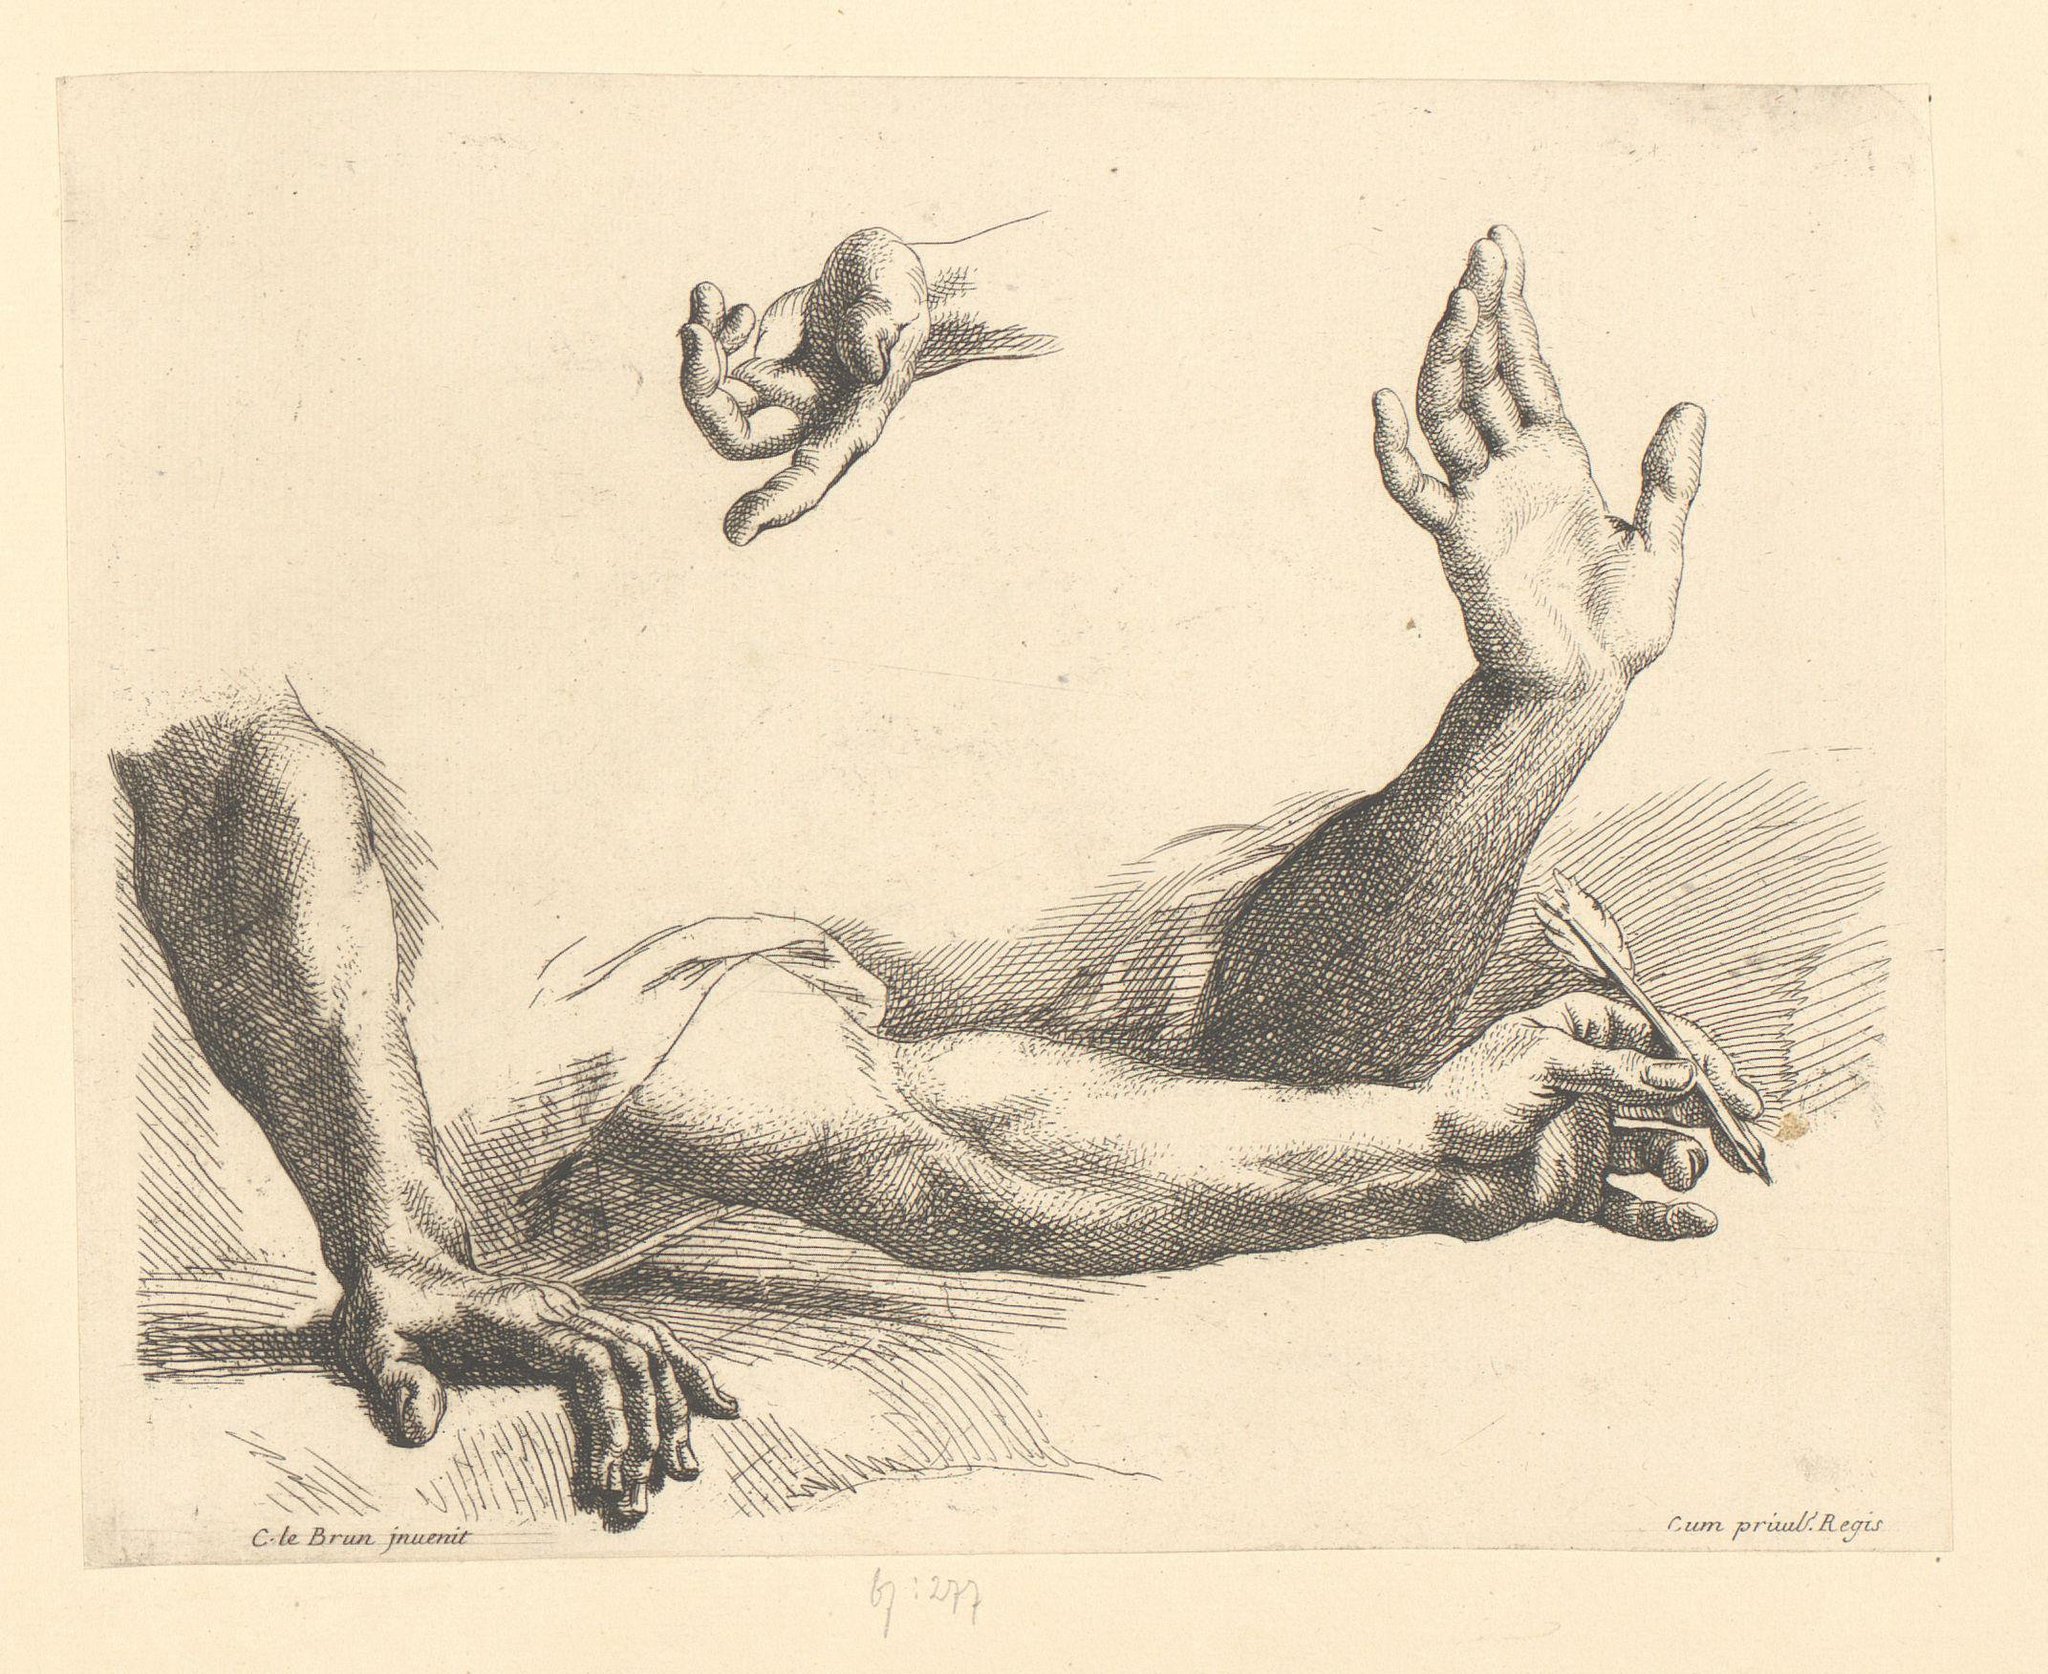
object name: print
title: Vier studies van handgebaren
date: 1700-1725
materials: paper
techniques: etching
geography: paris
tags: postures and gestures of hand and fingers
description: Deze prent maakt deel uit van de serie 'Livre de portraiture', die weer onderdeel is van de grotere reeks 'Oeuvre de Charles le Brun'.